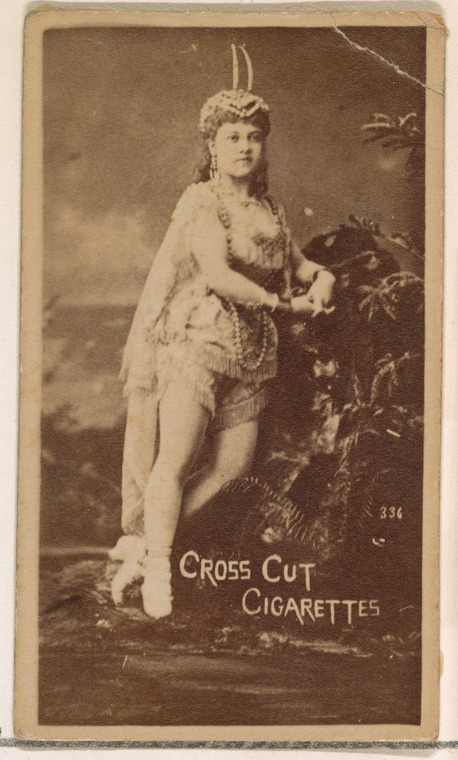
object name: print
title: Card Number 336, from the Actors and Actresses series (N145-1) issued by Duke Sons & Co. to promote Cross Cut Cigarettes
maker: w. duke, sons & co.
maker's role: publisher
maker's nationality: american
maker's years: 1870-1920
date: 1880-1889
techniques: albumen silver print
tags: portraits,women,actresses